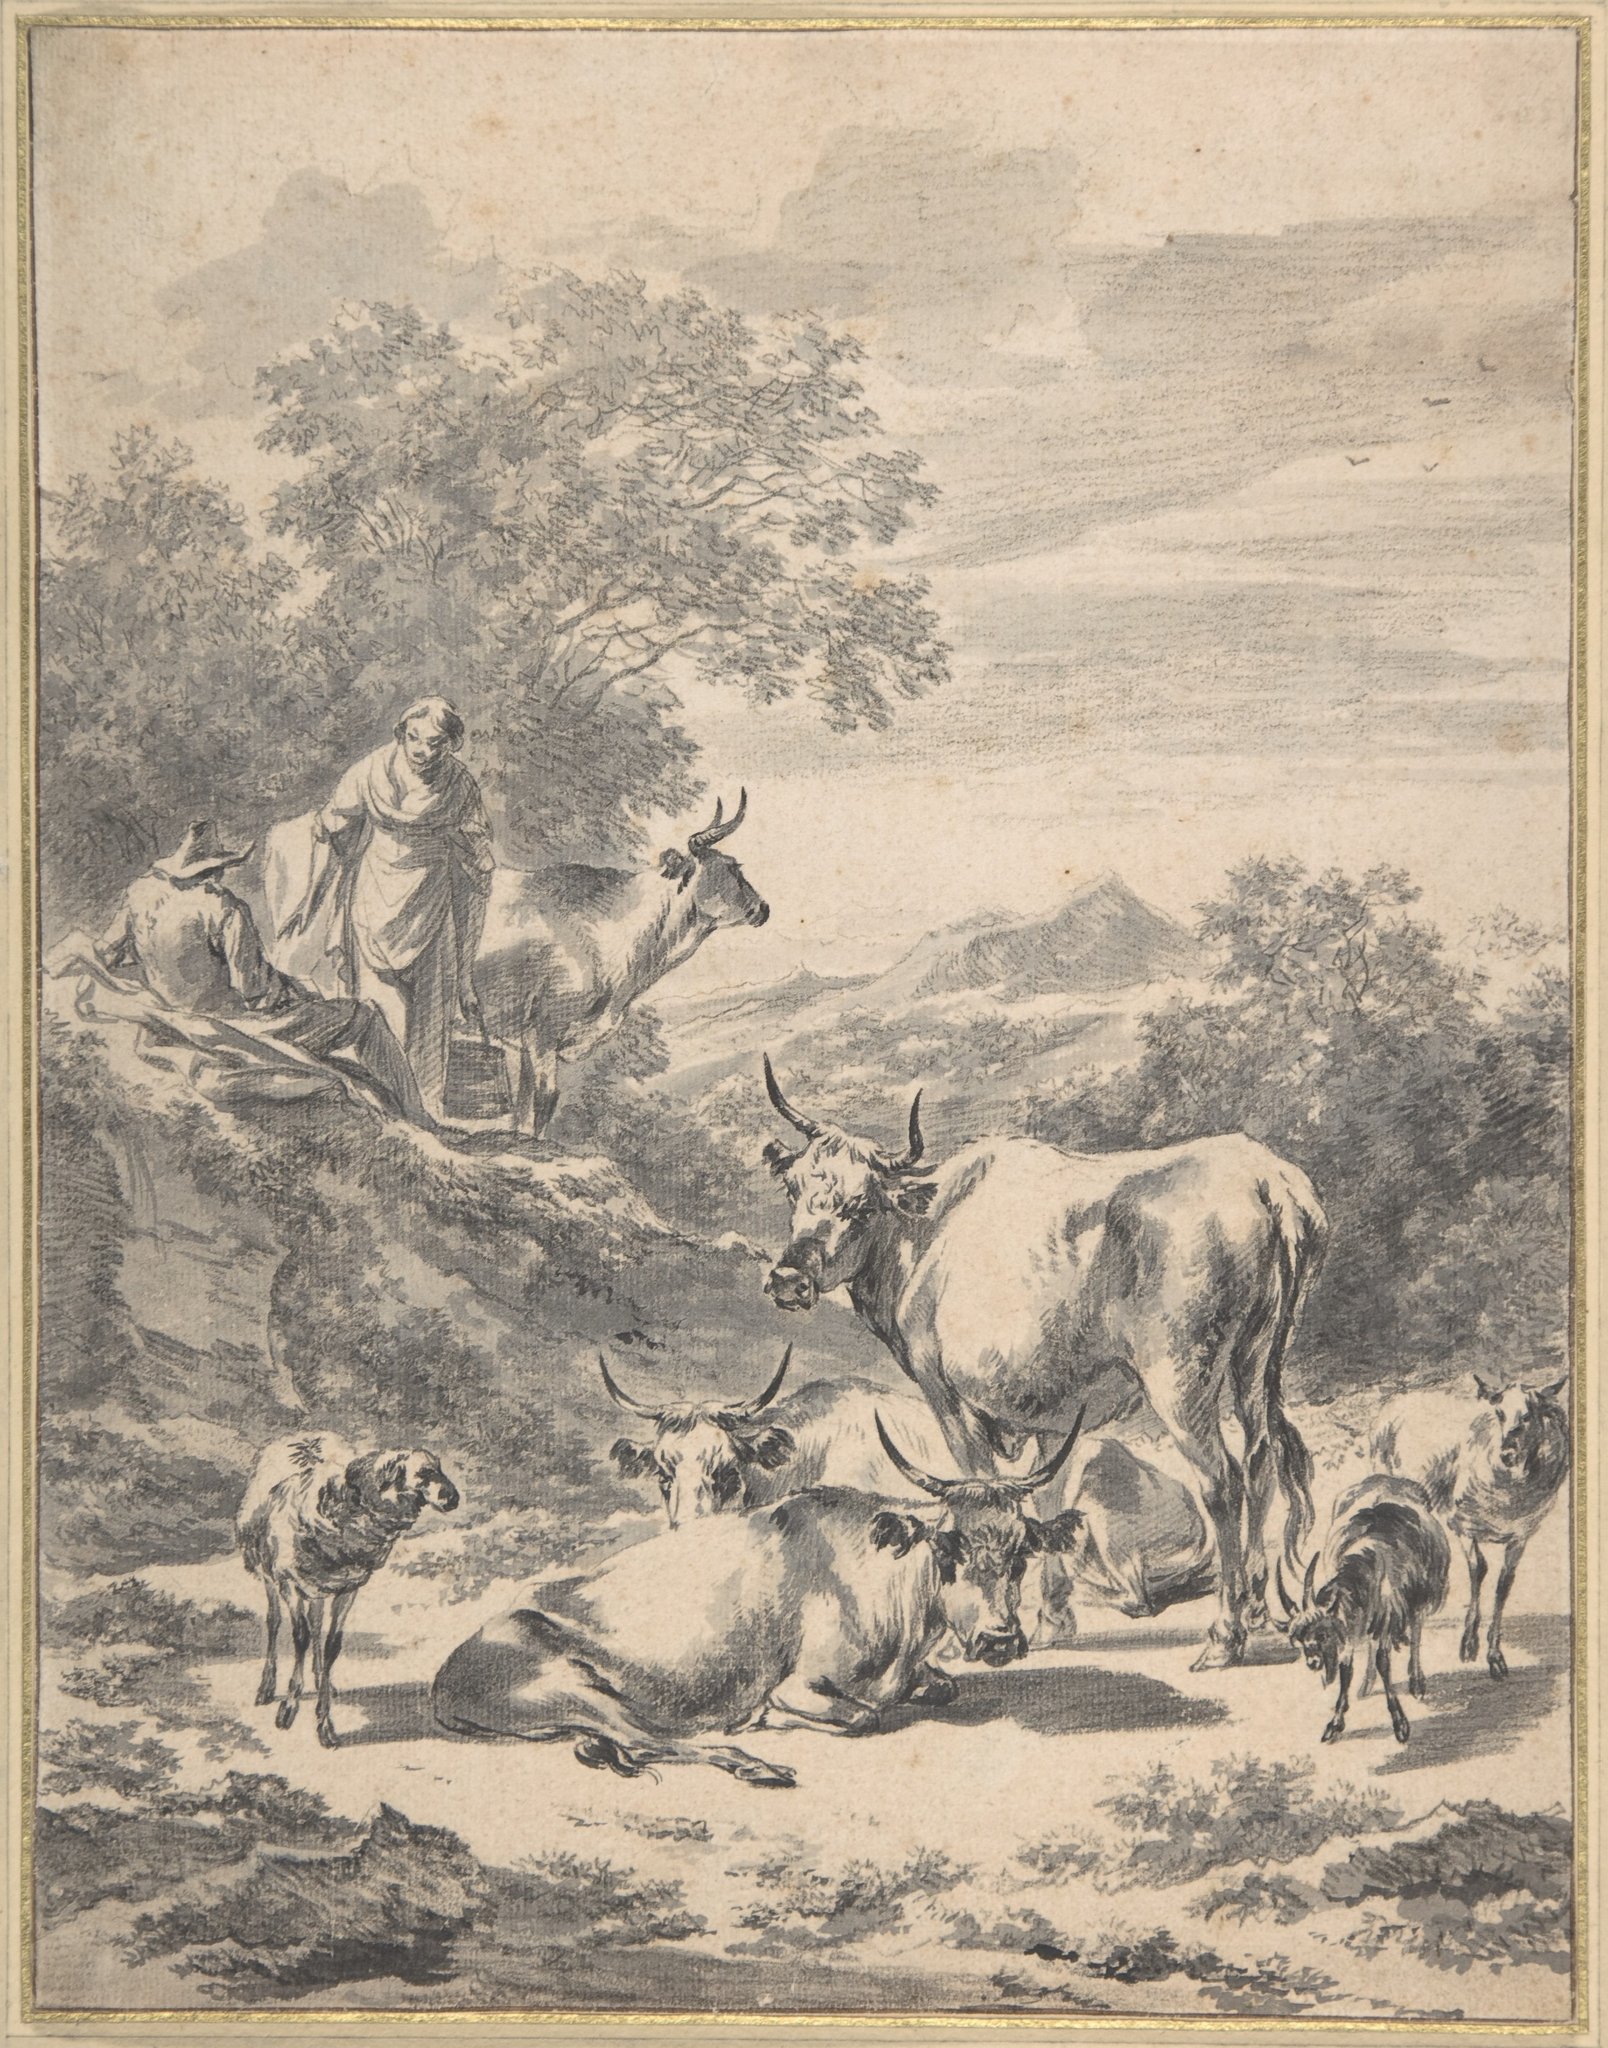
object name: drawing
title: Herdsmen with Cattle and Sheep in Italianate Landscape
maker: nicolaes pietersz berchem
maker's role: artist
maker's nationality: dutch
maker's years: 1620-1683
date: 1634-1700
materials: chalk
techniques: brush, wash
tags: men,women,cows,sheep,landscapes